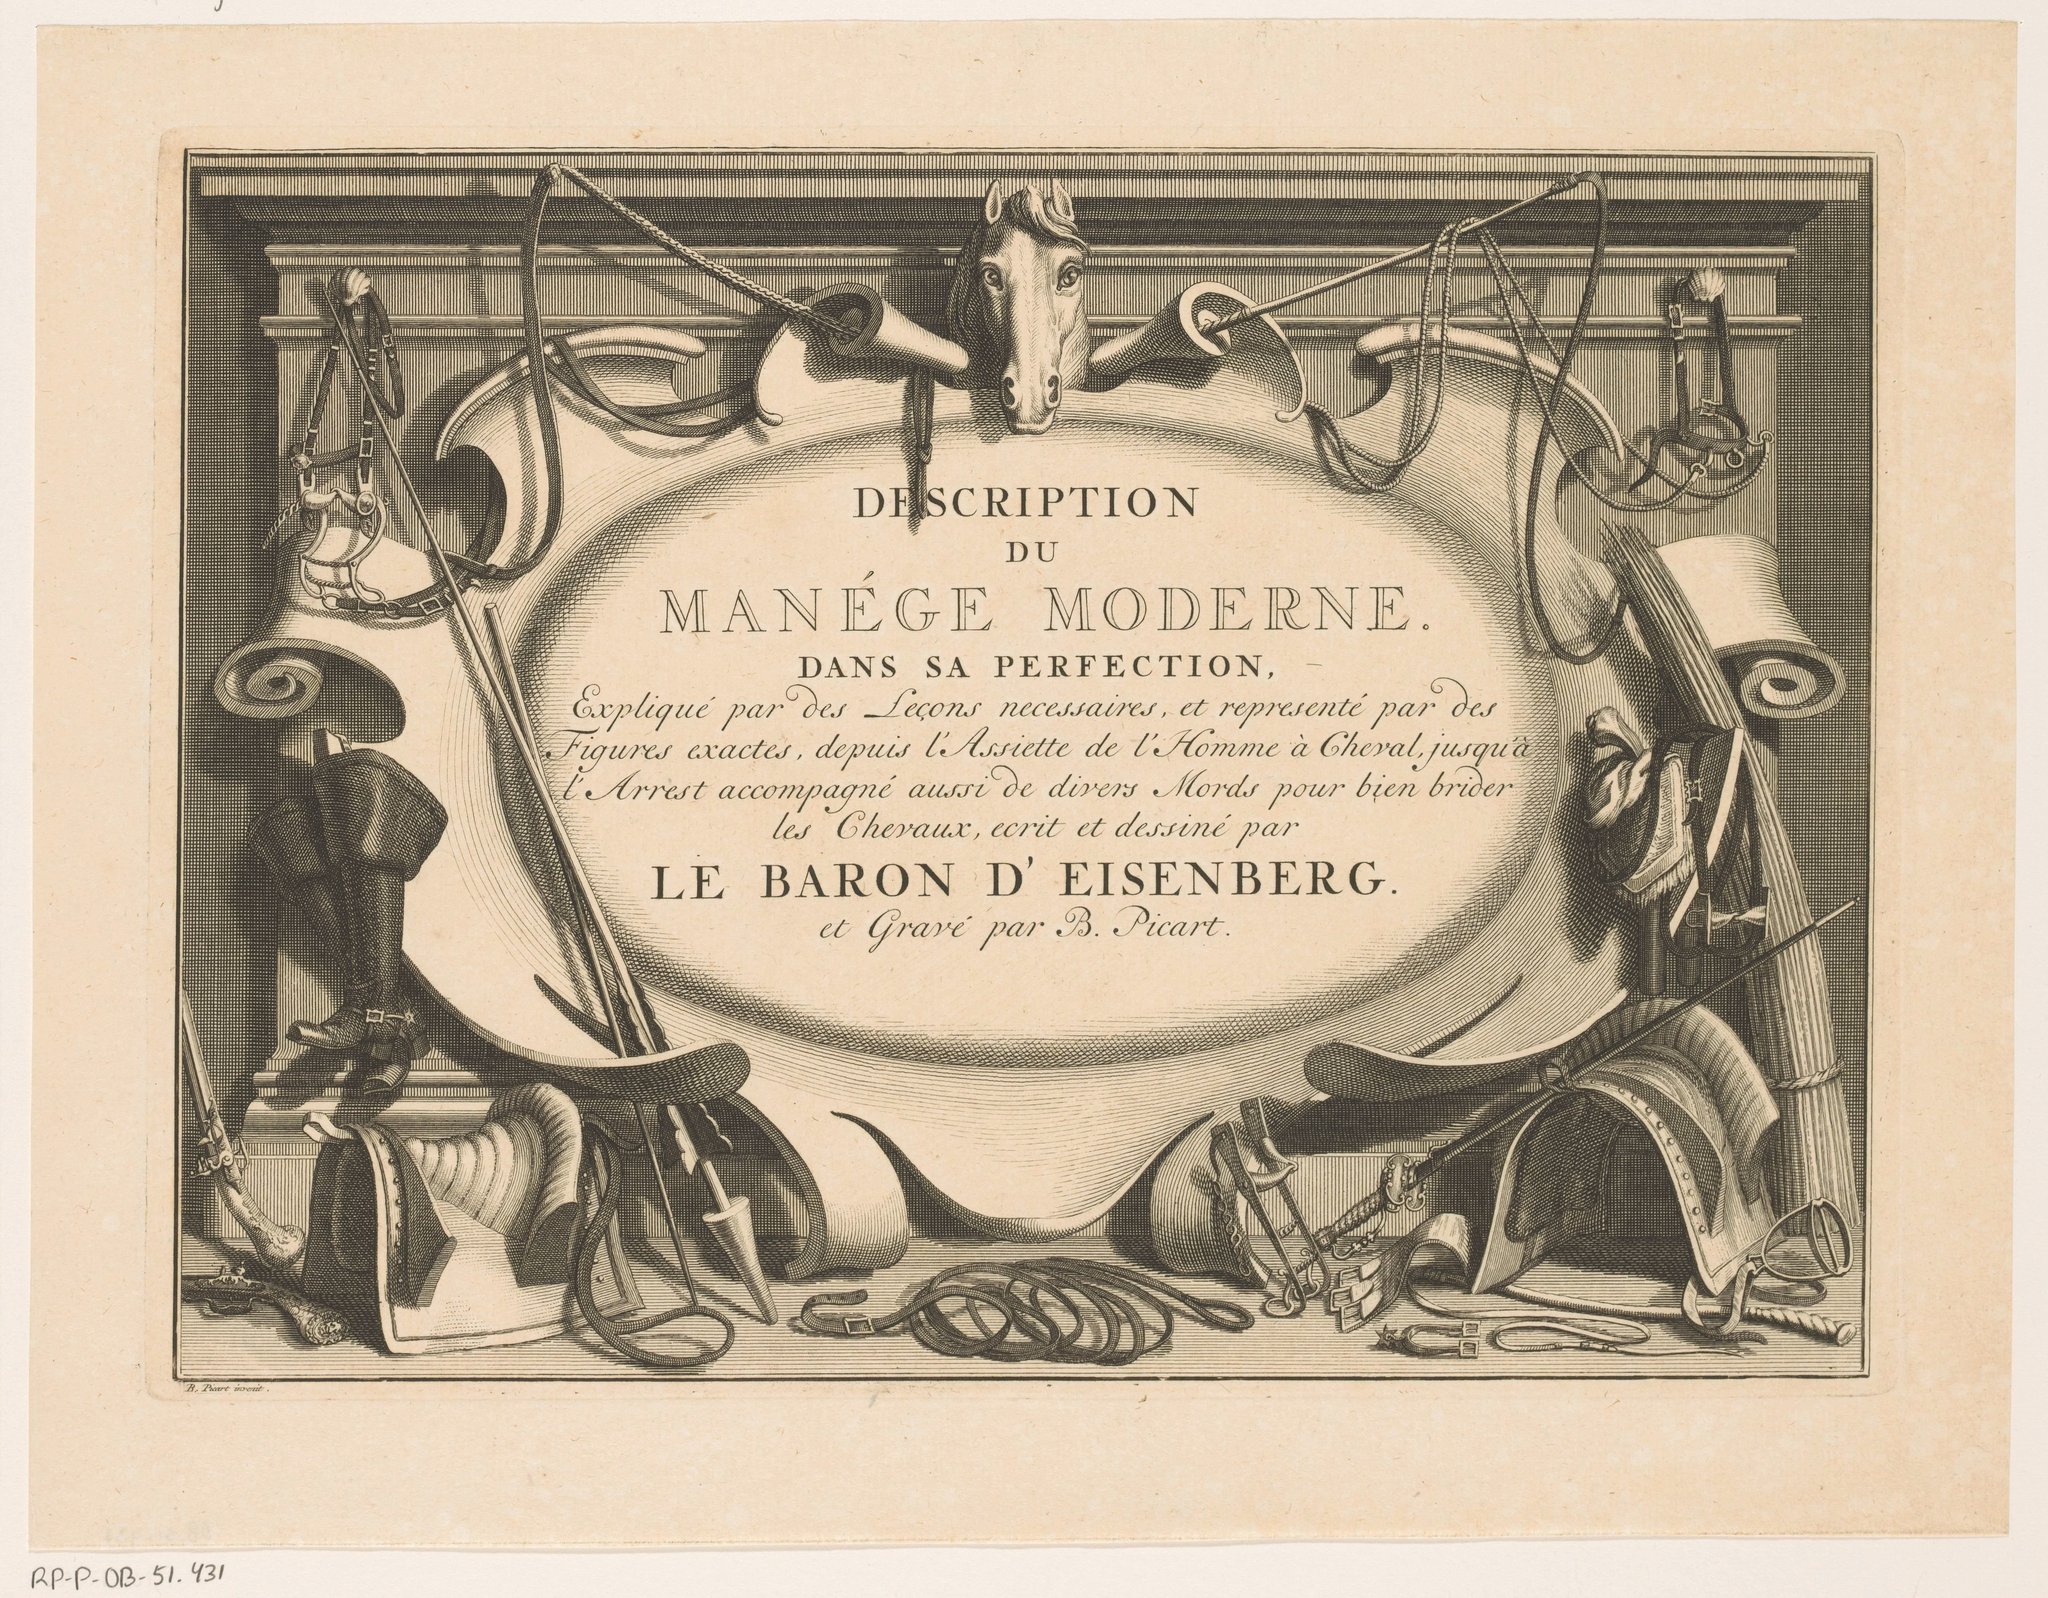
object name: print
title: Ornamentele omlijsting voor de beschrijving van de manege van baron van Eisenberg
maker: bernard picart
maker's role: draughtsman, print maker, publisher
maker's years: 1673-1733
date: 1727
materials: paper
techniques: engraving, etching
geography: amsterdam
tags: saddle and bridle (saddlery), title-page, reins, bit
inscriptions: collector's mark: Lugt 2228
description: Titelpagina voor: Eisenberg, Reis d'. L'art de monter a cheval, ou Description du manége moderne. Den Haag: Pierre Gosse en Jean Neaulme, 1733.